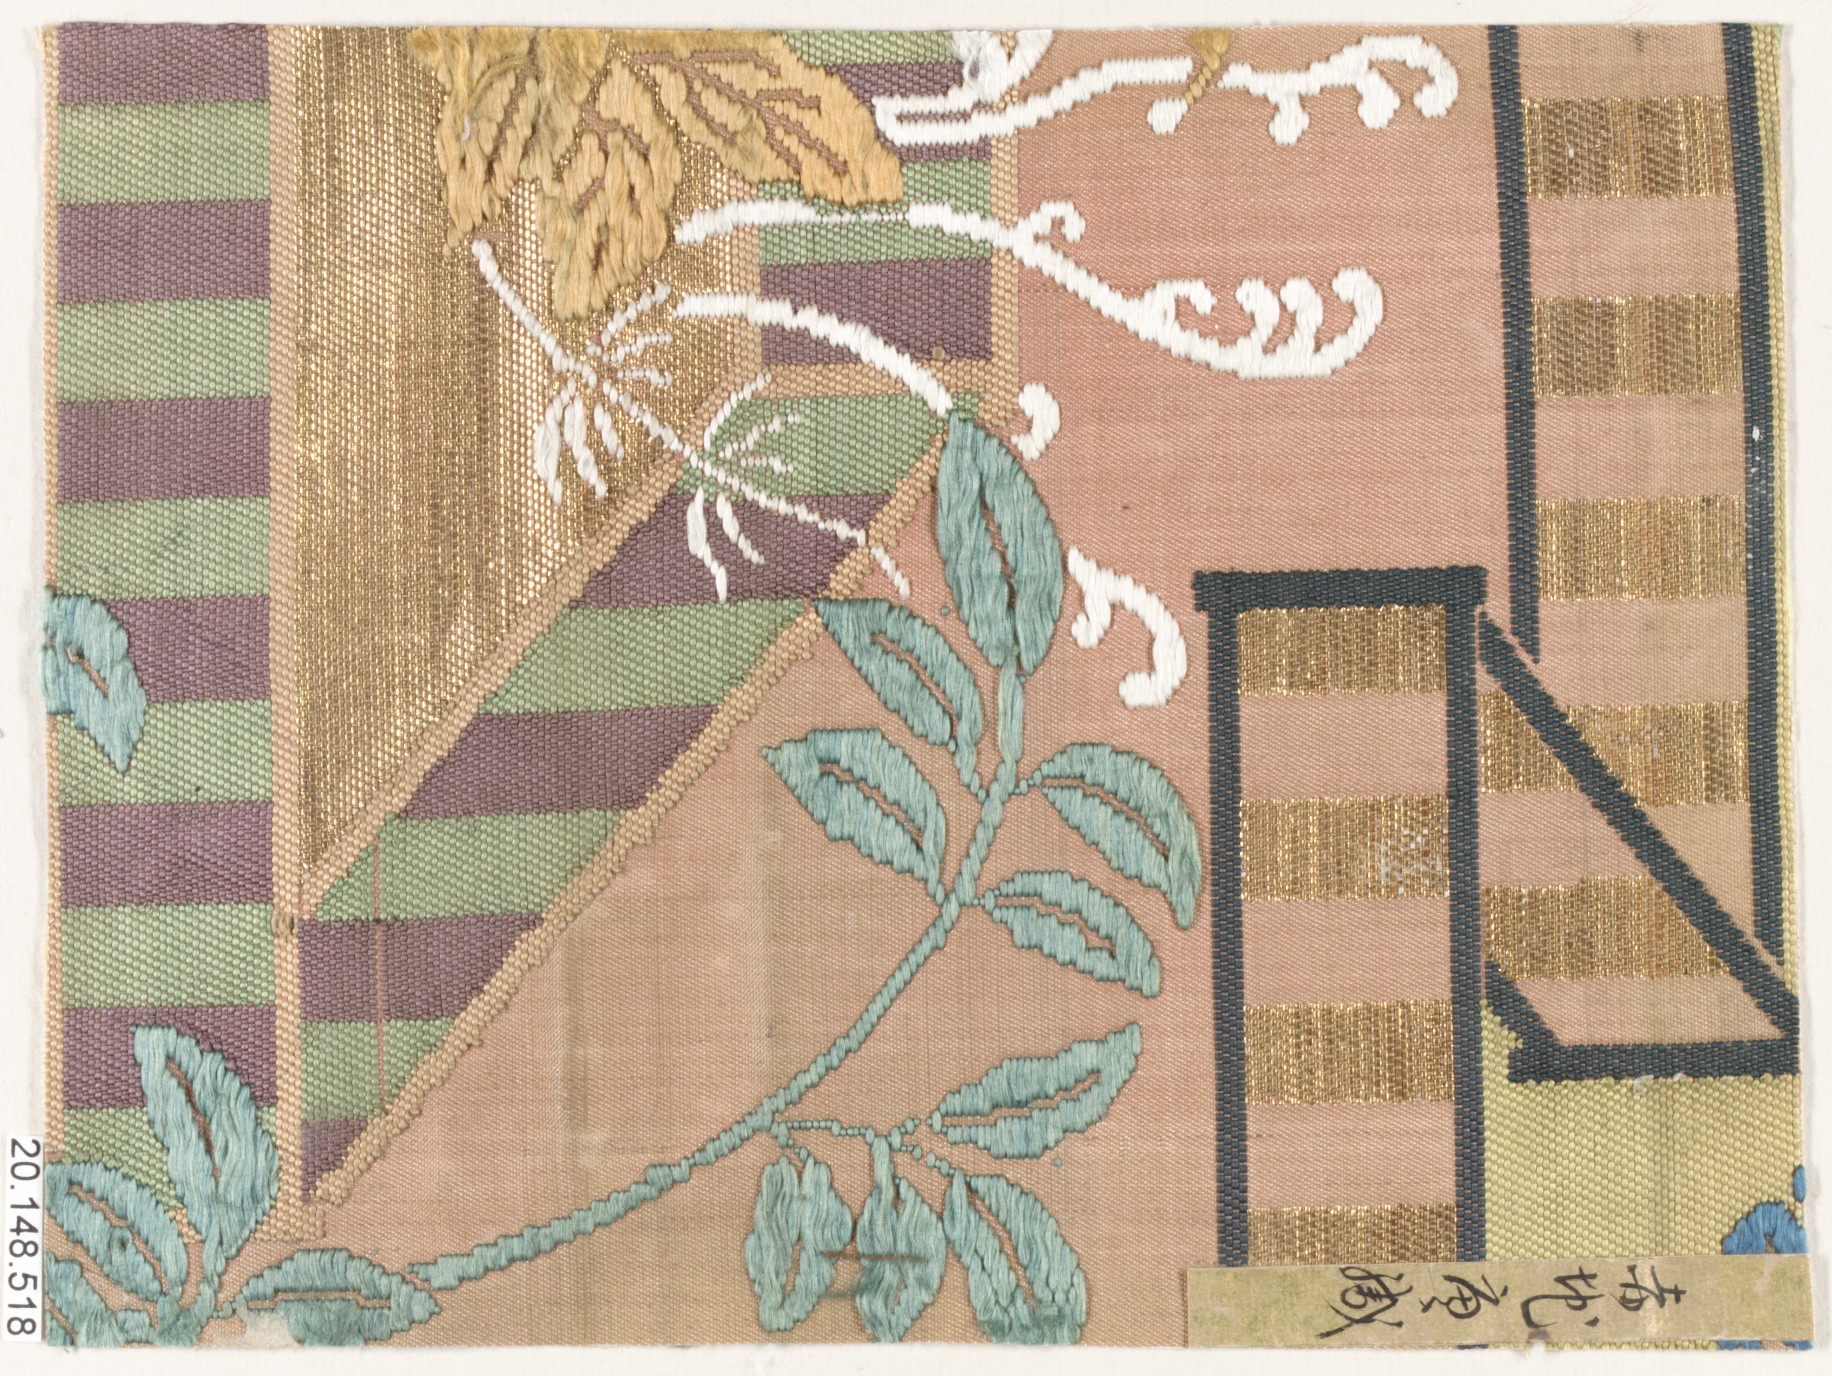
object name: piece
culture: japanese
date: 1601-1700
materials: silk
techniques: compound weave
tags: leaves